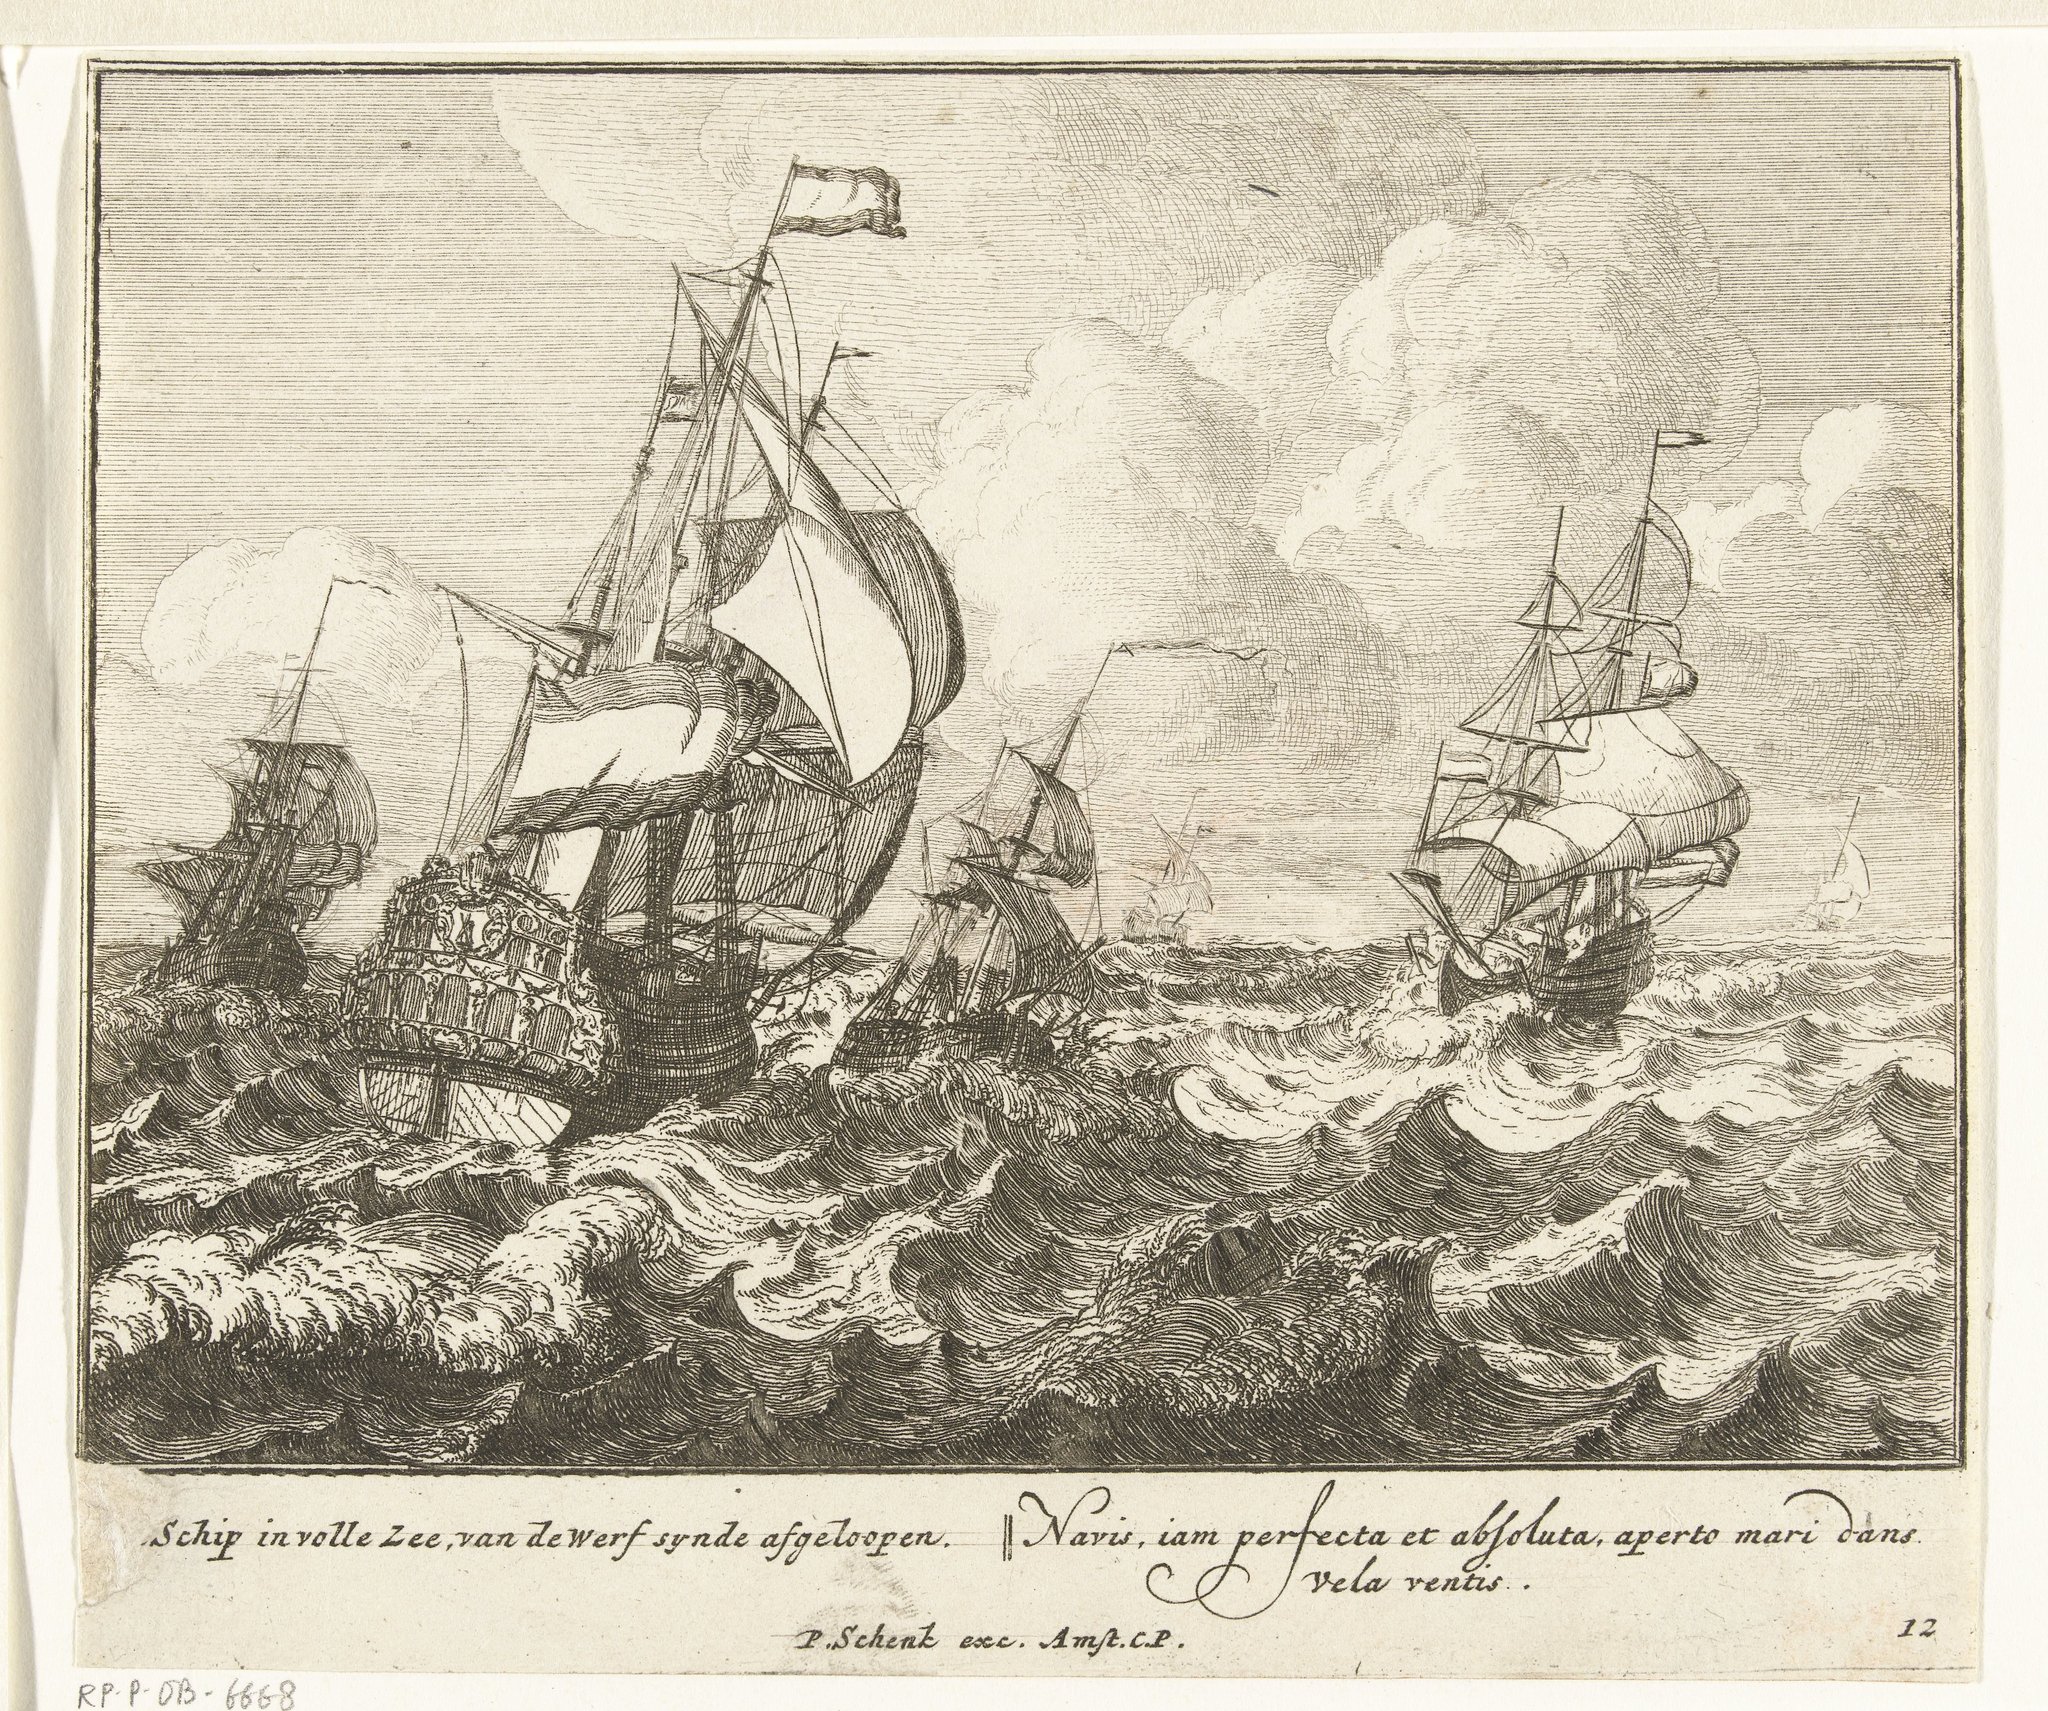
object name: print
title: De bouw en de lotgevallen van een schip in 16 platen, ca. 1700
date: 1690-1710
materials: paper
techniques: etching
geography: amsterdam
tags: ships (in general) (+ propulsion of vehicle, ship, etc. by wind)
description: Het schip zeilend op de volle zee. No. 12 uit serie van 16 prenten waarop de bouw en lotgevallen van een schip zijn afgebeeld. Met onderschriften in het Nederlands en Latijn.